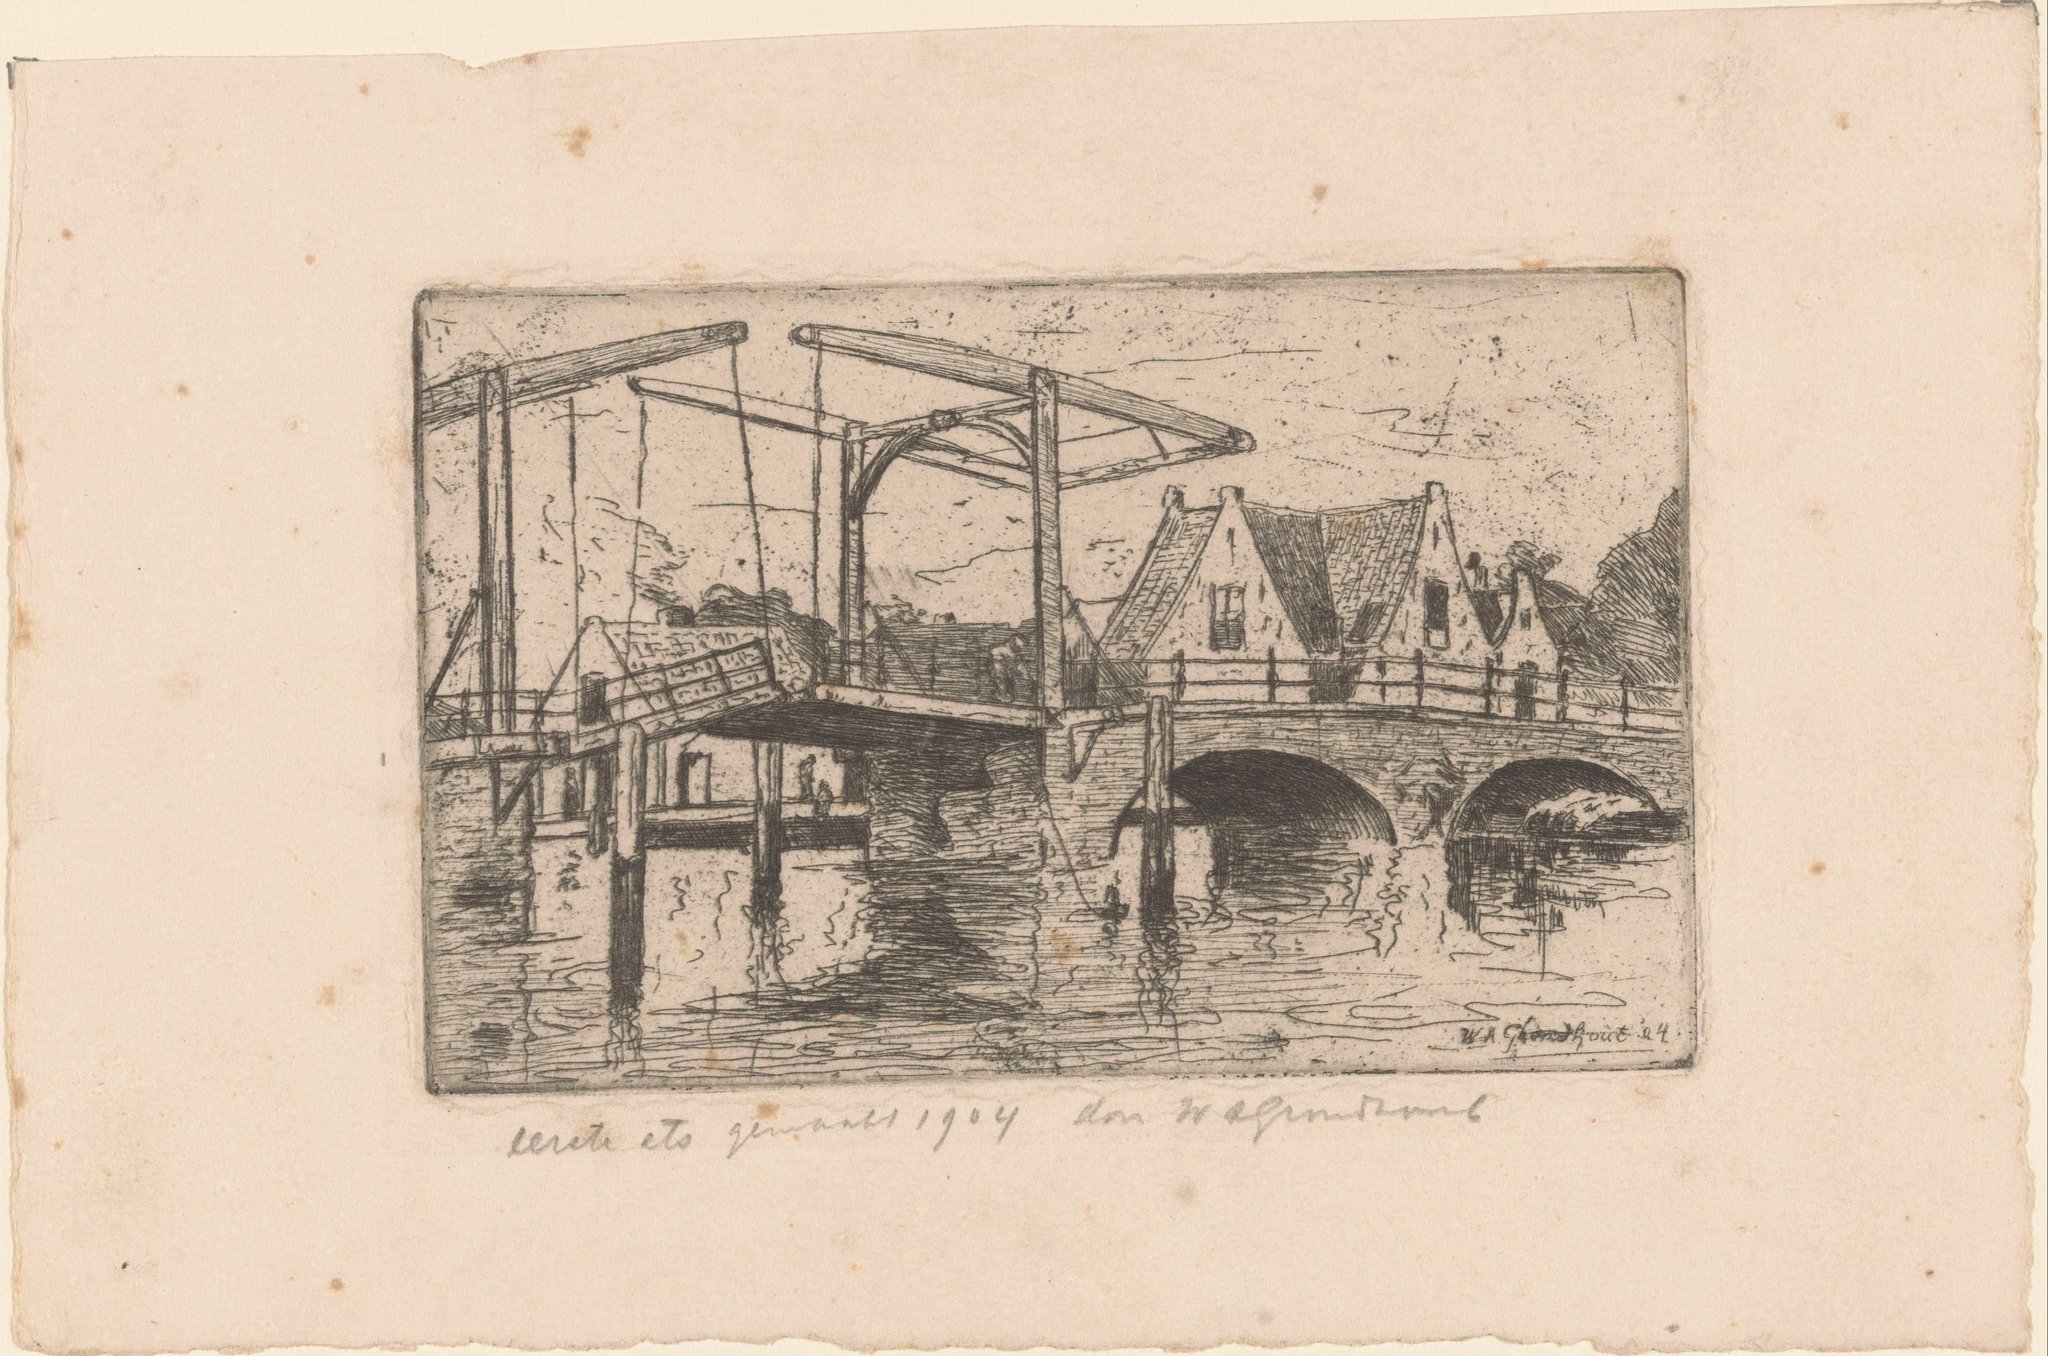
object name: print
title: Ophaalbrug in een stad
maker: willem adrianus grondhout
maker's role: draughtsman, painter, print maker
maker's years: 1878-1934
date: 1904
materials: paper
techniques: etching, intaglio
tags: bascule bridge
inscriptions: collector's mark: Lugt 2228, inscription: ‘eerste ets’